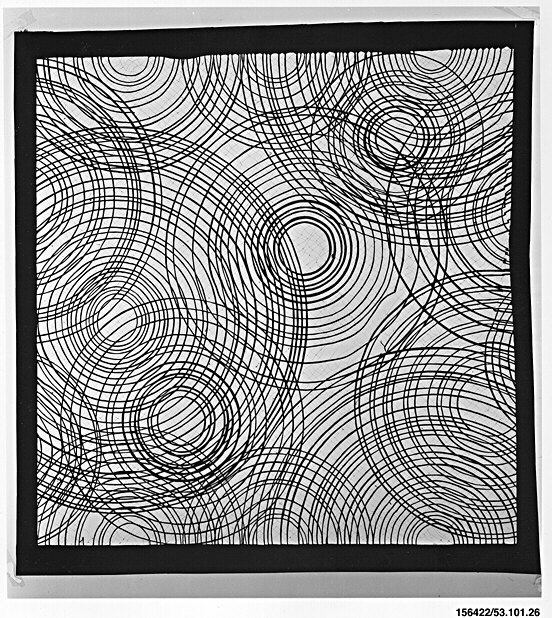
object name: stencil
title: Stencil with Pattern of Concentric Circles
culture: japanese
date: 1801-1900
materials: paper, silk